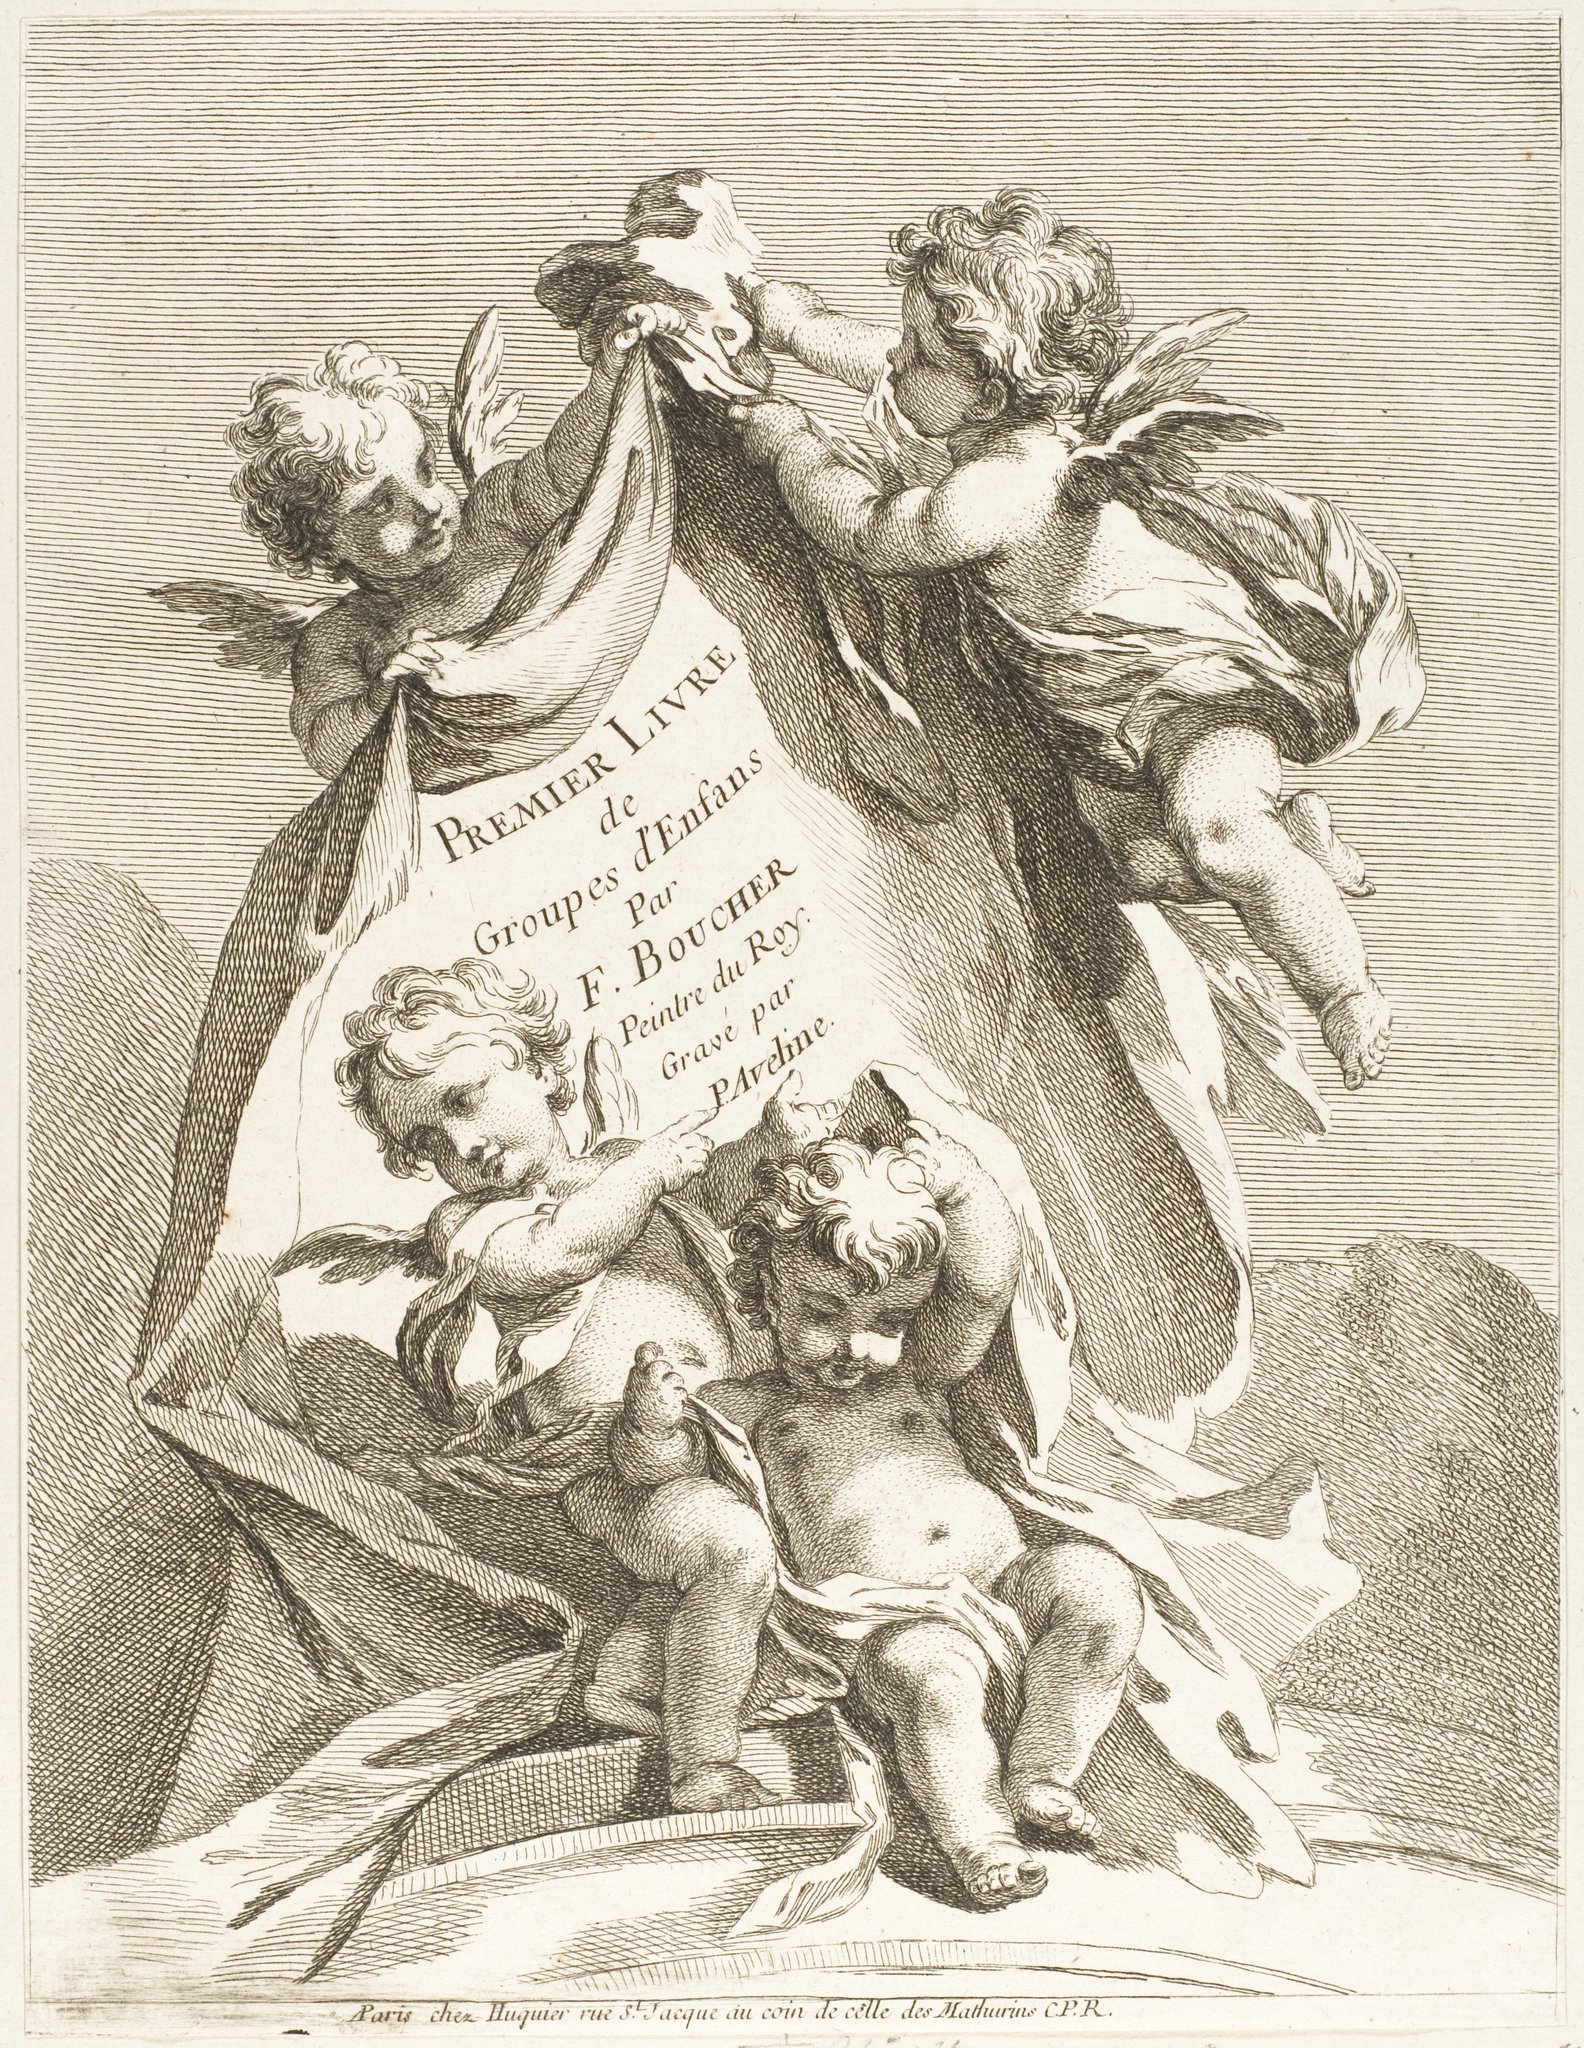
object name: print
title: Frontispiece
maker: pierre alexandre aveline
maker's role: artist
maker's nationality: french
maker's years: 1702-1760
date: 1727-1760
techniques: engraving, etching